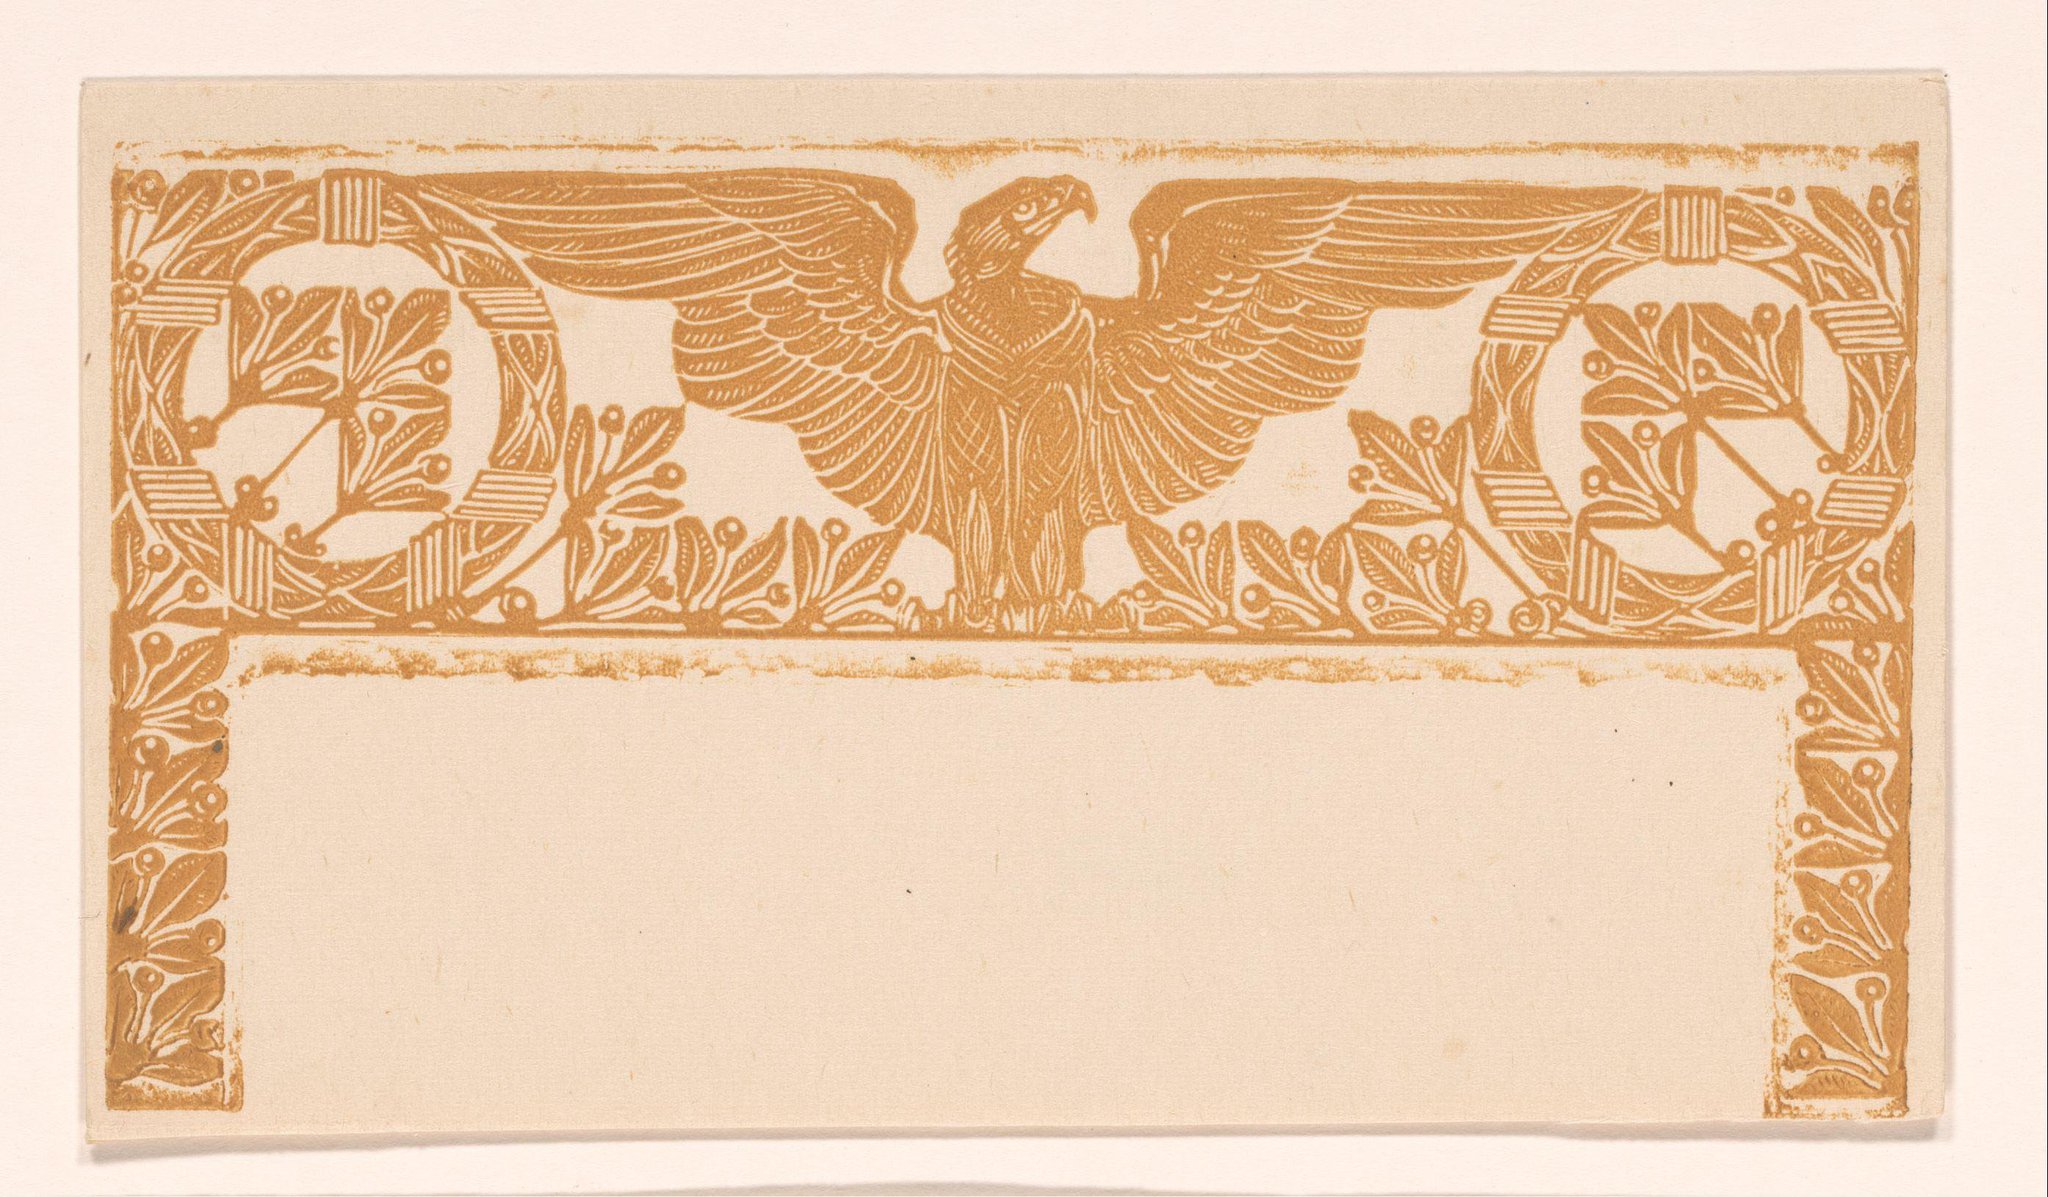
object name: boekillustratie ontwerp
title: Ornamentele rand met bladeren en adelaar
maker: bernard willem wierink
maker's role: draughtsman, print maker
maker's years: 1856-1939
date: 1910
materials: paper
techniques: relief print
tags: predatory birds: eagle, fable of reynard the fox, foliage, tendrils, branches ~ ornament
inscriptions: collector's mark: Lugt 2228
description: Ontwerp voor: Streuvels, Stijn (Frank Lateur). Reinaert de Vos naar verschillende uitgaven van het middeleeuwsche epos. Amsterdam: L.J. Veen, 1910. Deze prent is vermoedelijk een plaatsnede, ook al wordt in de literatuur veelal gesproken over een houtsnede. Voor zover Wierink zijn prenten in hoogdruk zelf nader heeft omschreven, heeft hij altijd de term 'plaatsnede' gebruikt.